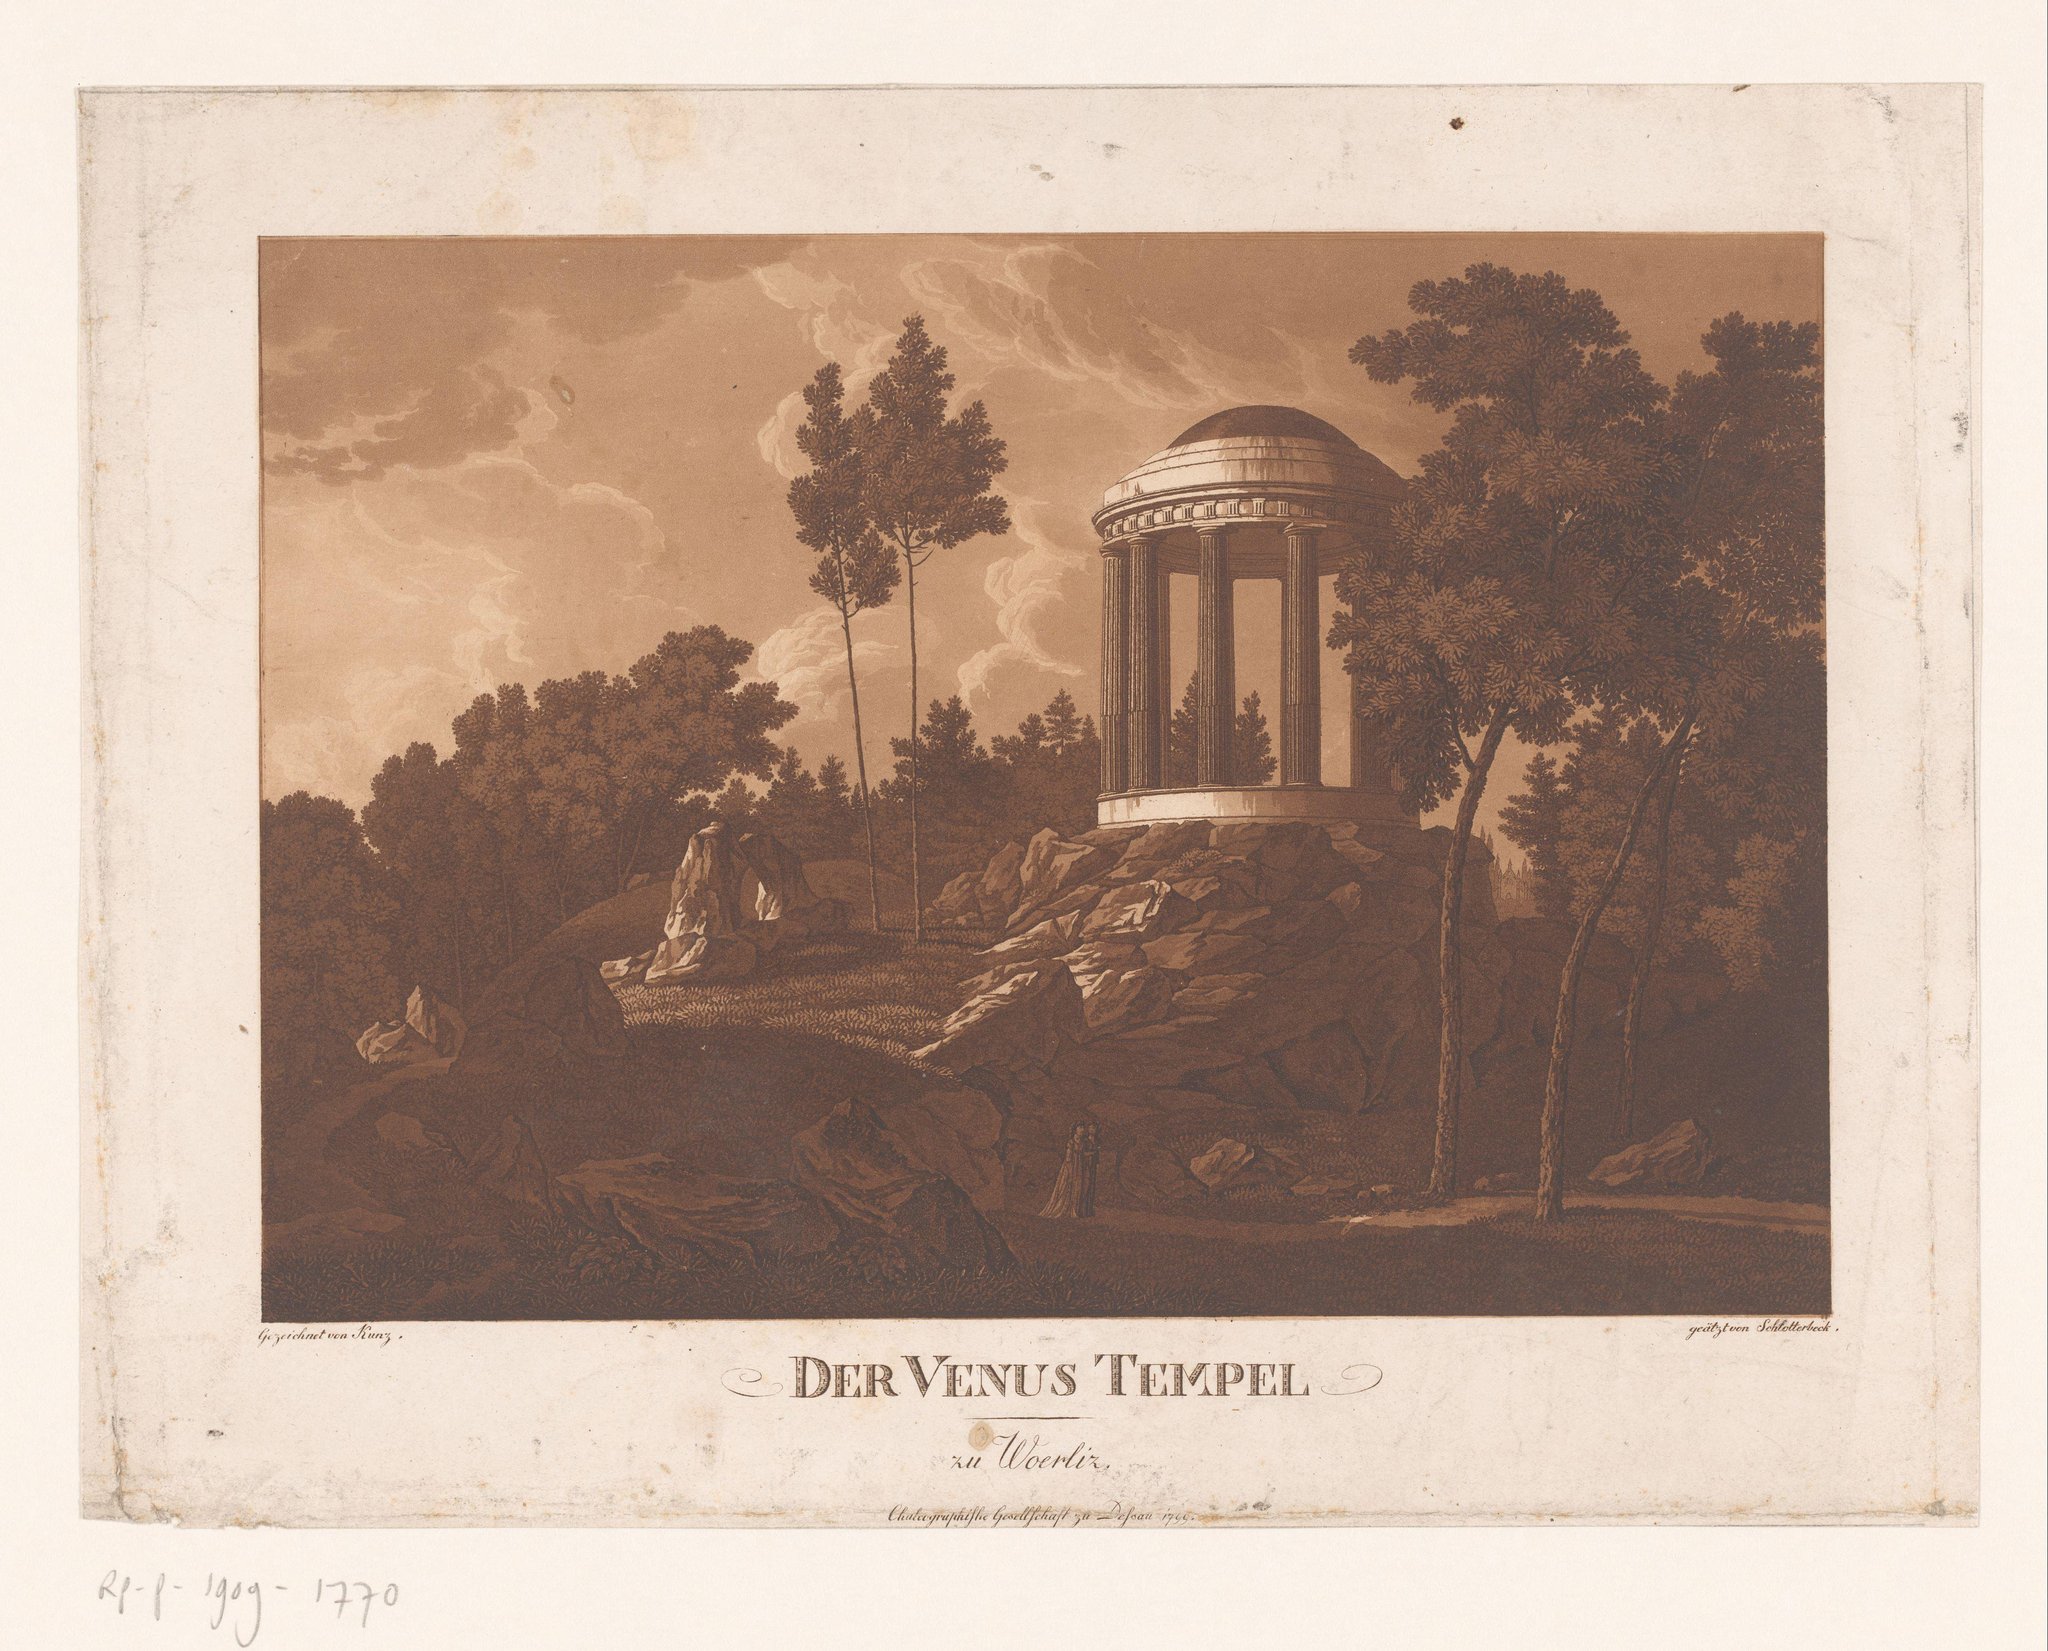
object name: print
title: Venus tempel in Parklandschap Dessau-Wörlitz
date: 1799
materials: paper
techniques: aquatint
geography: dessau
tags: architectural folly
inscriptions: collector's mark: Lugt 2228